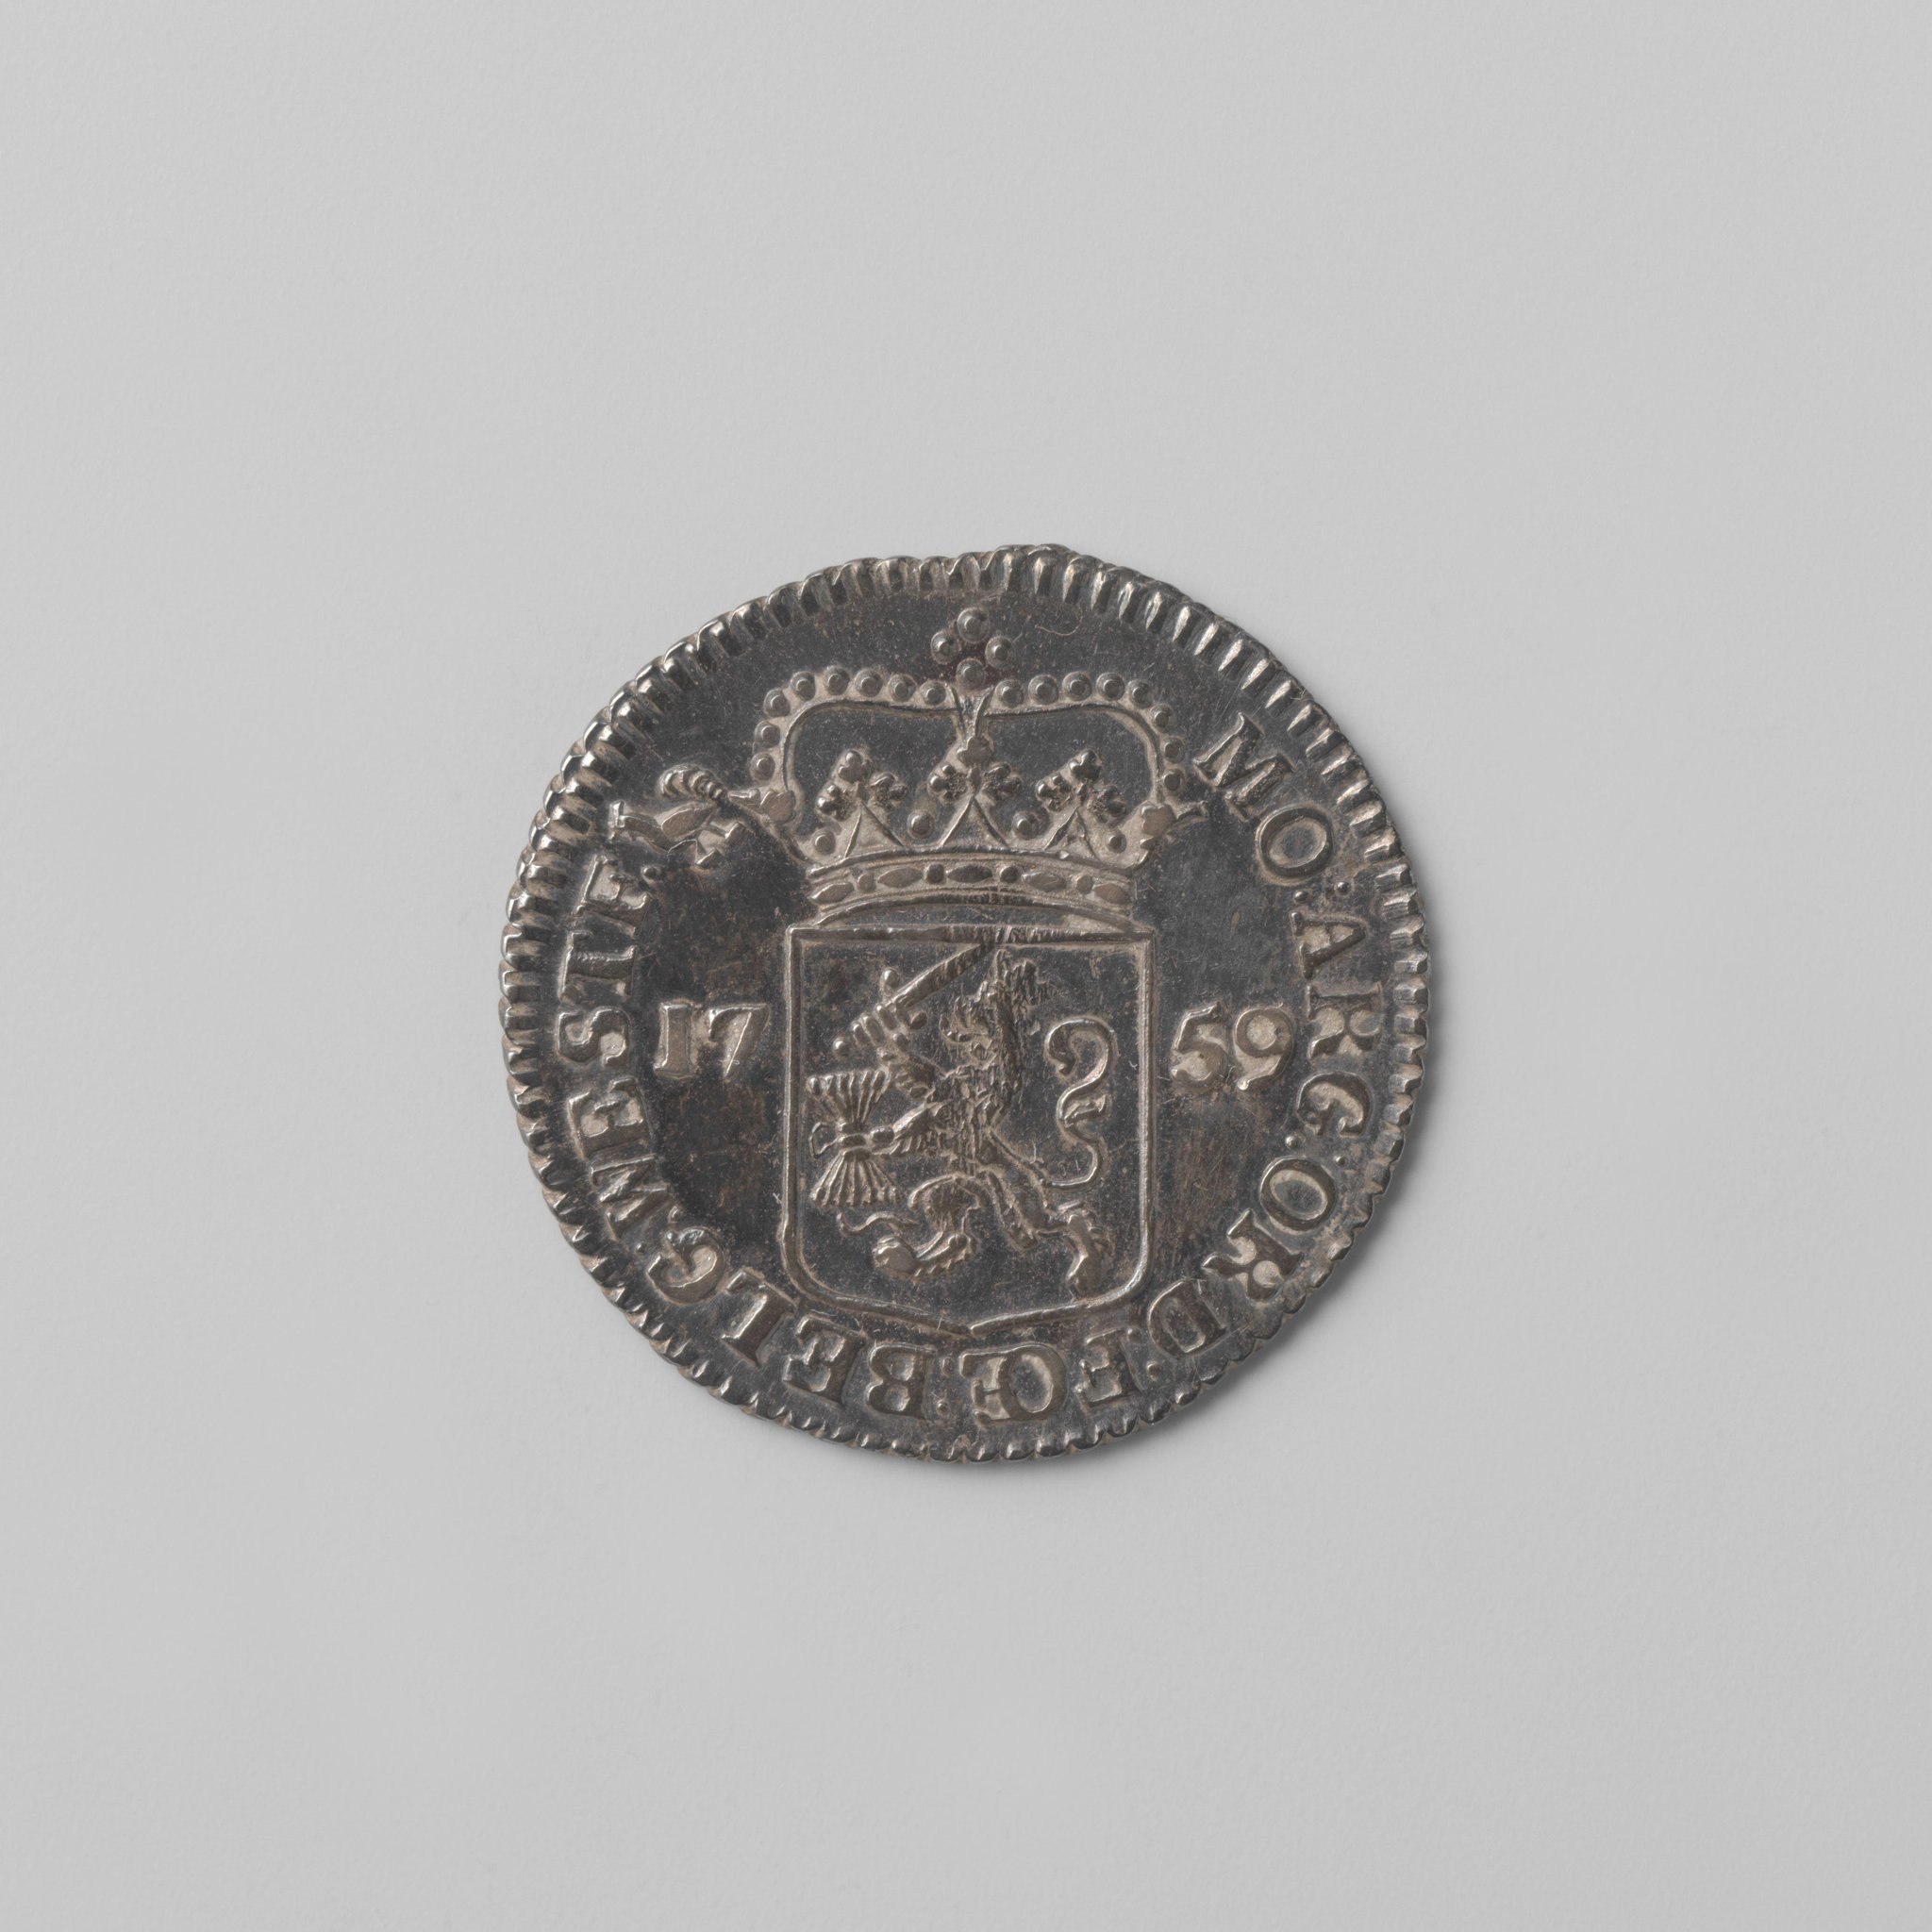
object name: coin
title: Westfriese kwart gulden, 1759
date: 1759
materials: silver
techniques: striking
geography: west frisia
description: Voorzijde: tussen jaartal gekroond generaliteirtswapenschild. Keerzijde: Nederlandse maagd met vrijheidshoed en speer, leunend op een bijbel op een altaar. Kabelrand. Zogenaamde muntmeesterpenning.